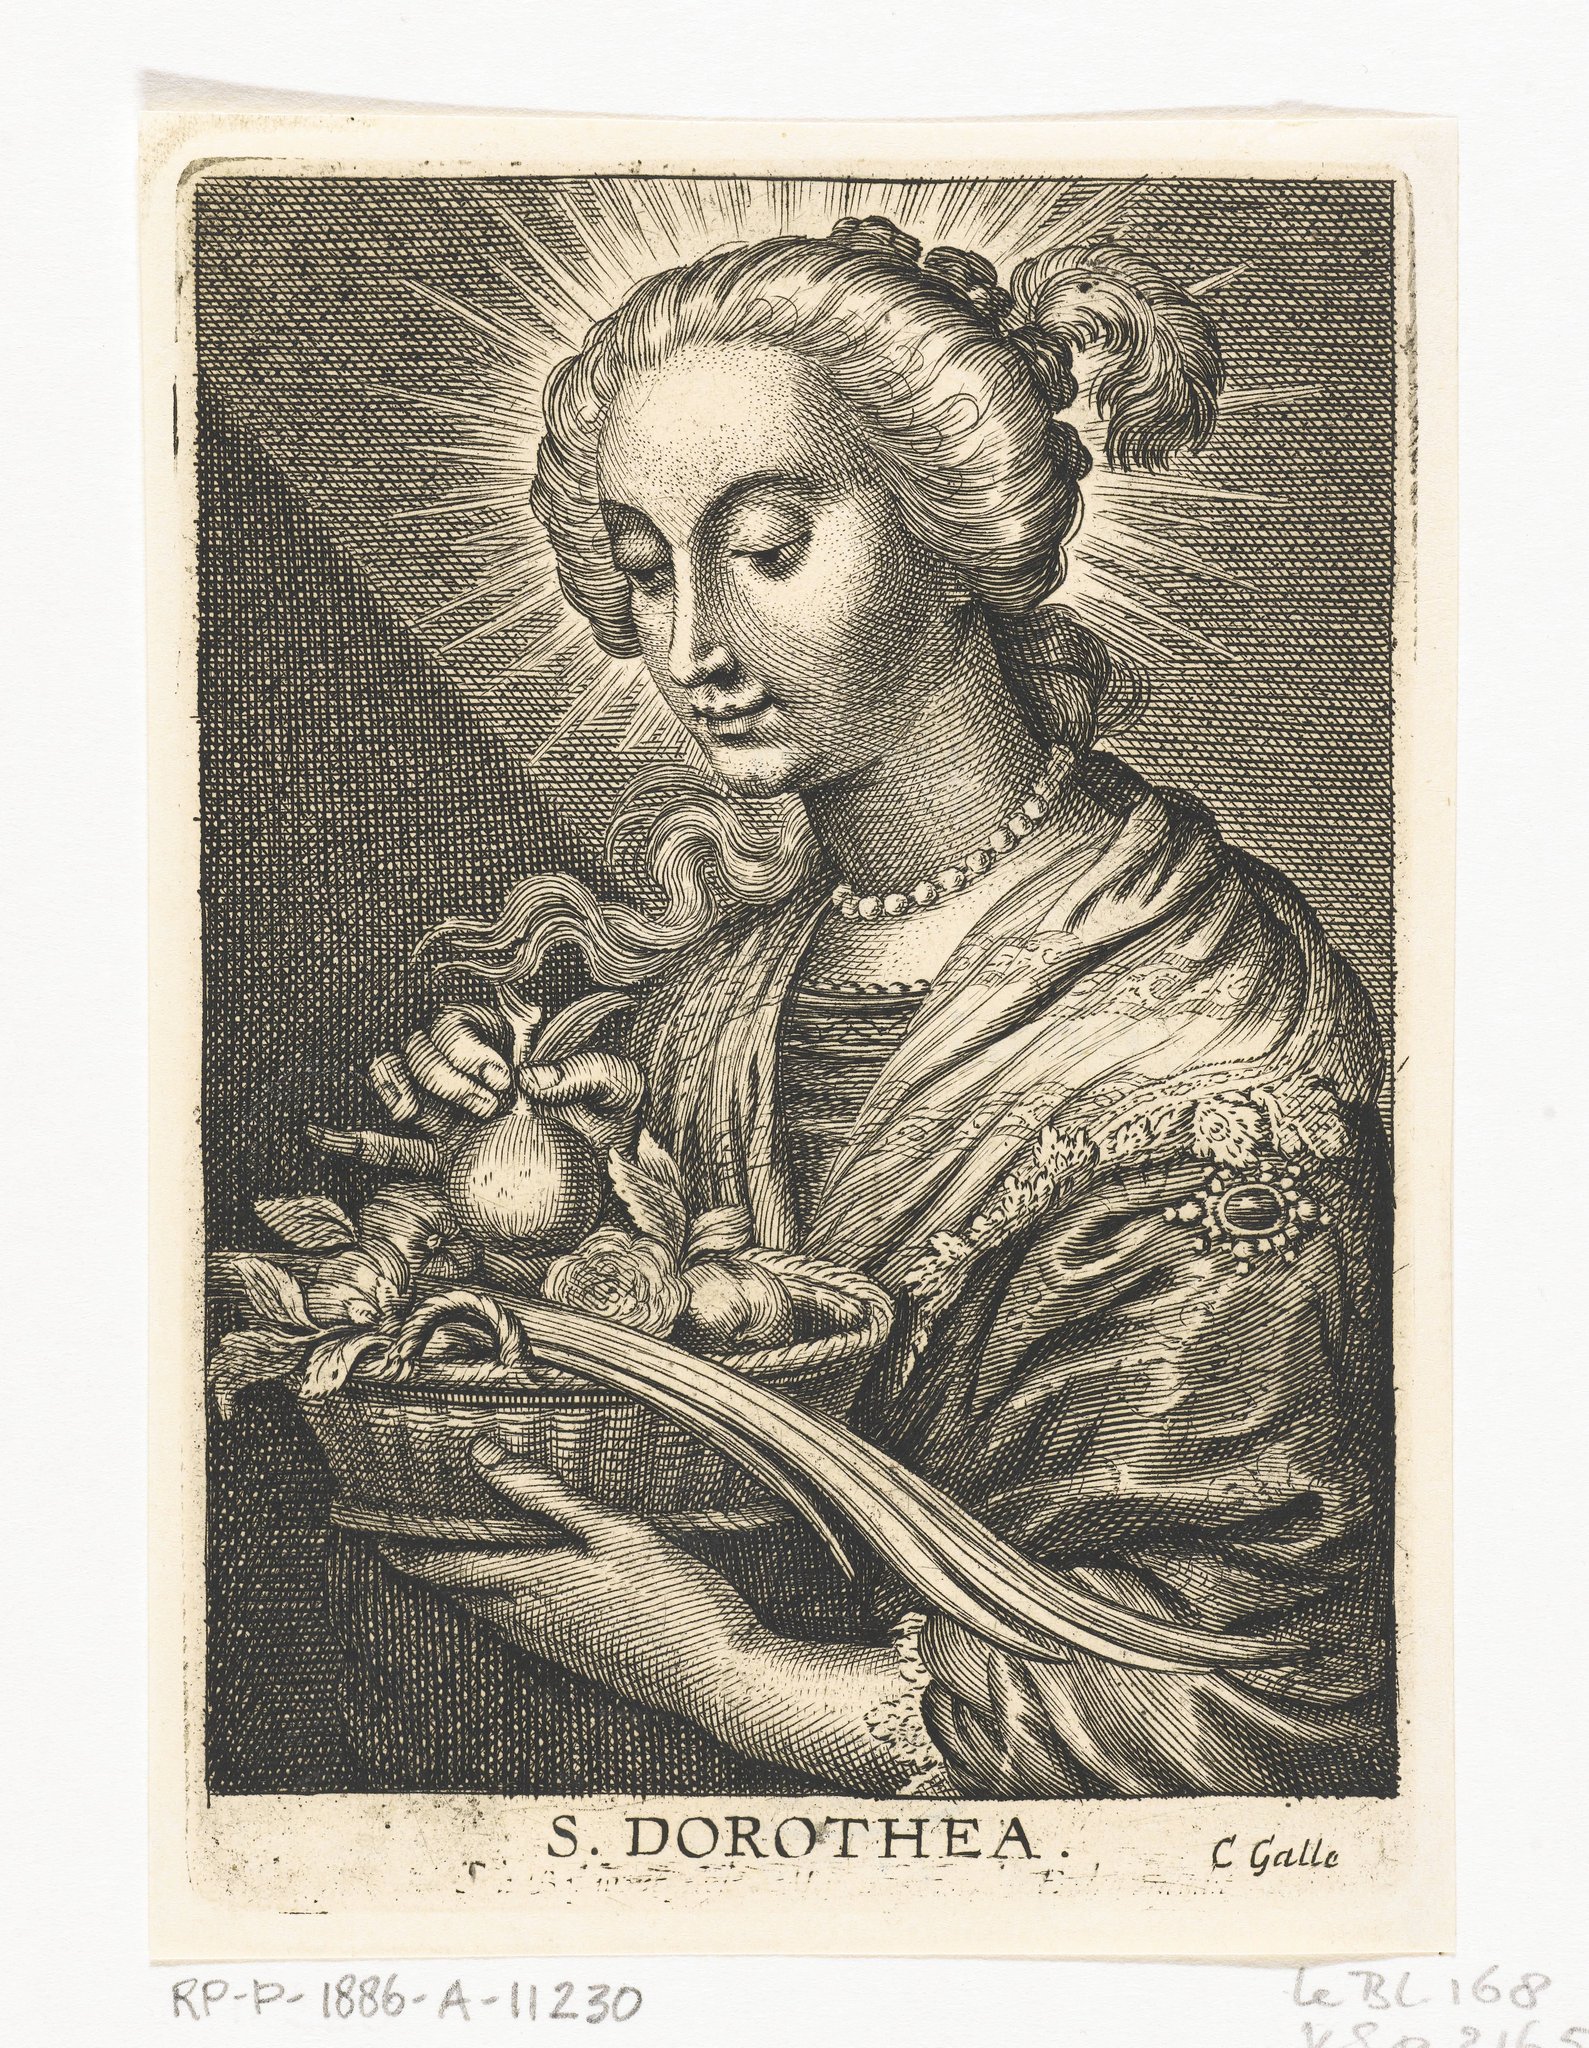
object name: print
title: S. Dorothea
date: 1596-1659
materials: paper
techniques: engraving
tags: the virgin martyr dorothea of caesarea; possible attributes: basket of roses and apples, child with basket of roses, garland of roses, roses in hand or lap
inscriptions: collector's mark: Lugt 2228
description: Prent naar ontwerp van Peter Paul Rubens.